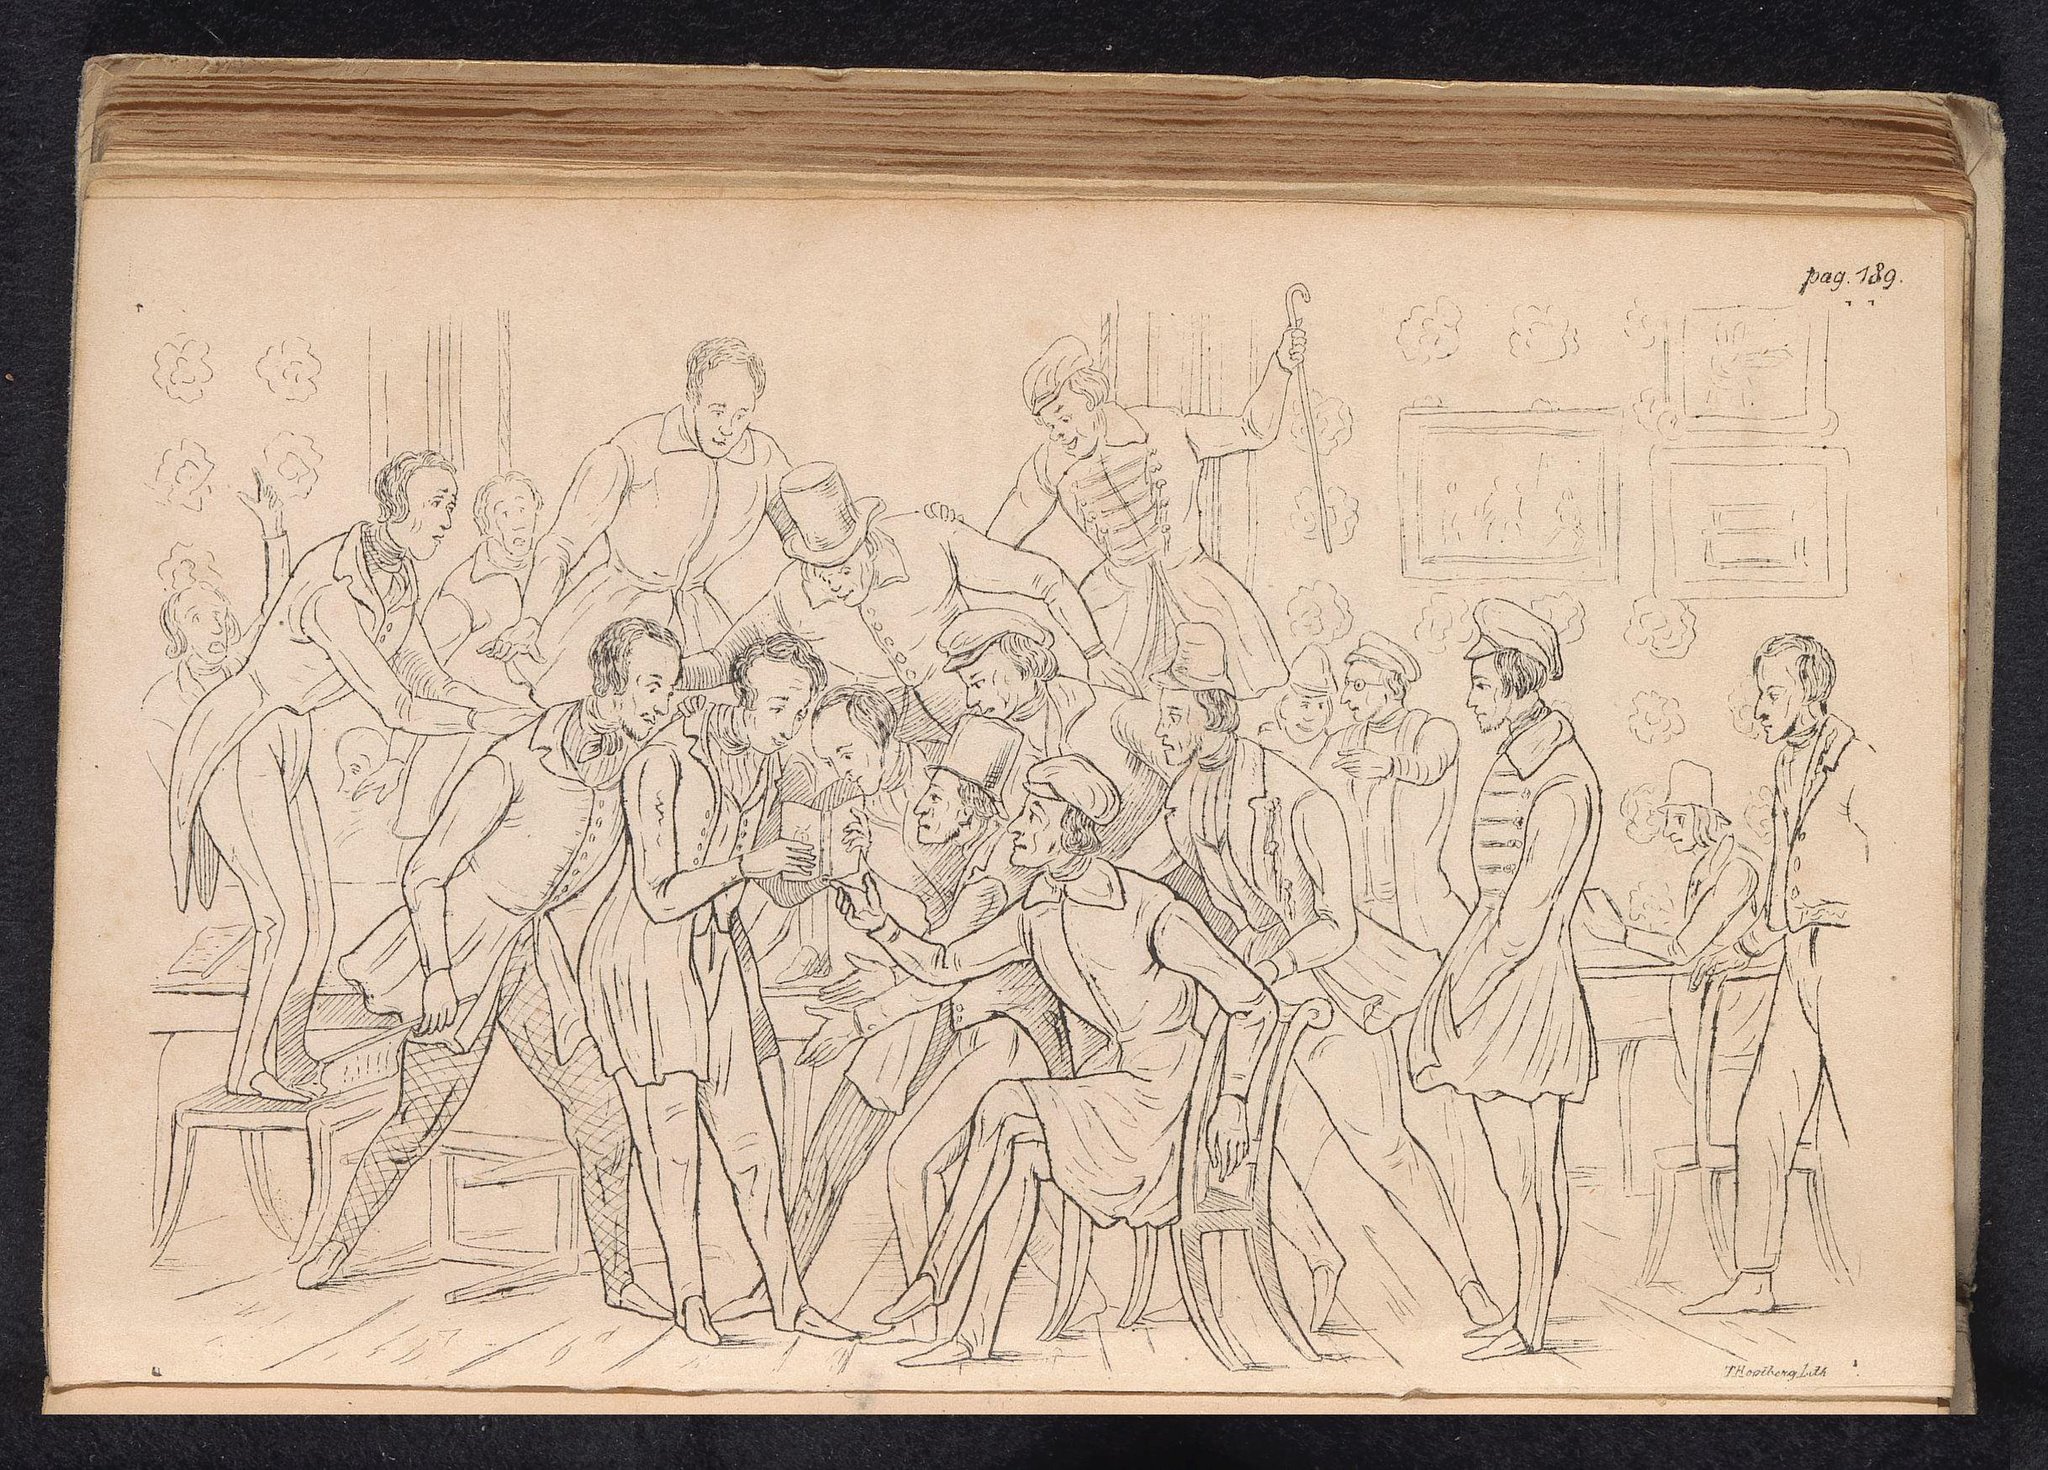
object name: book illustration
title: Ontvangst van de almanak op de sociëteit, 1841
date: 1841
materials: paper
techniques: lithograph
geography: leiden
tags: student life, leiden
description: Ontvangst van de almanak op de sociëteit. Spotprent in de studentenalmanak van de Universiteit van Leiden van het jaar 1841.